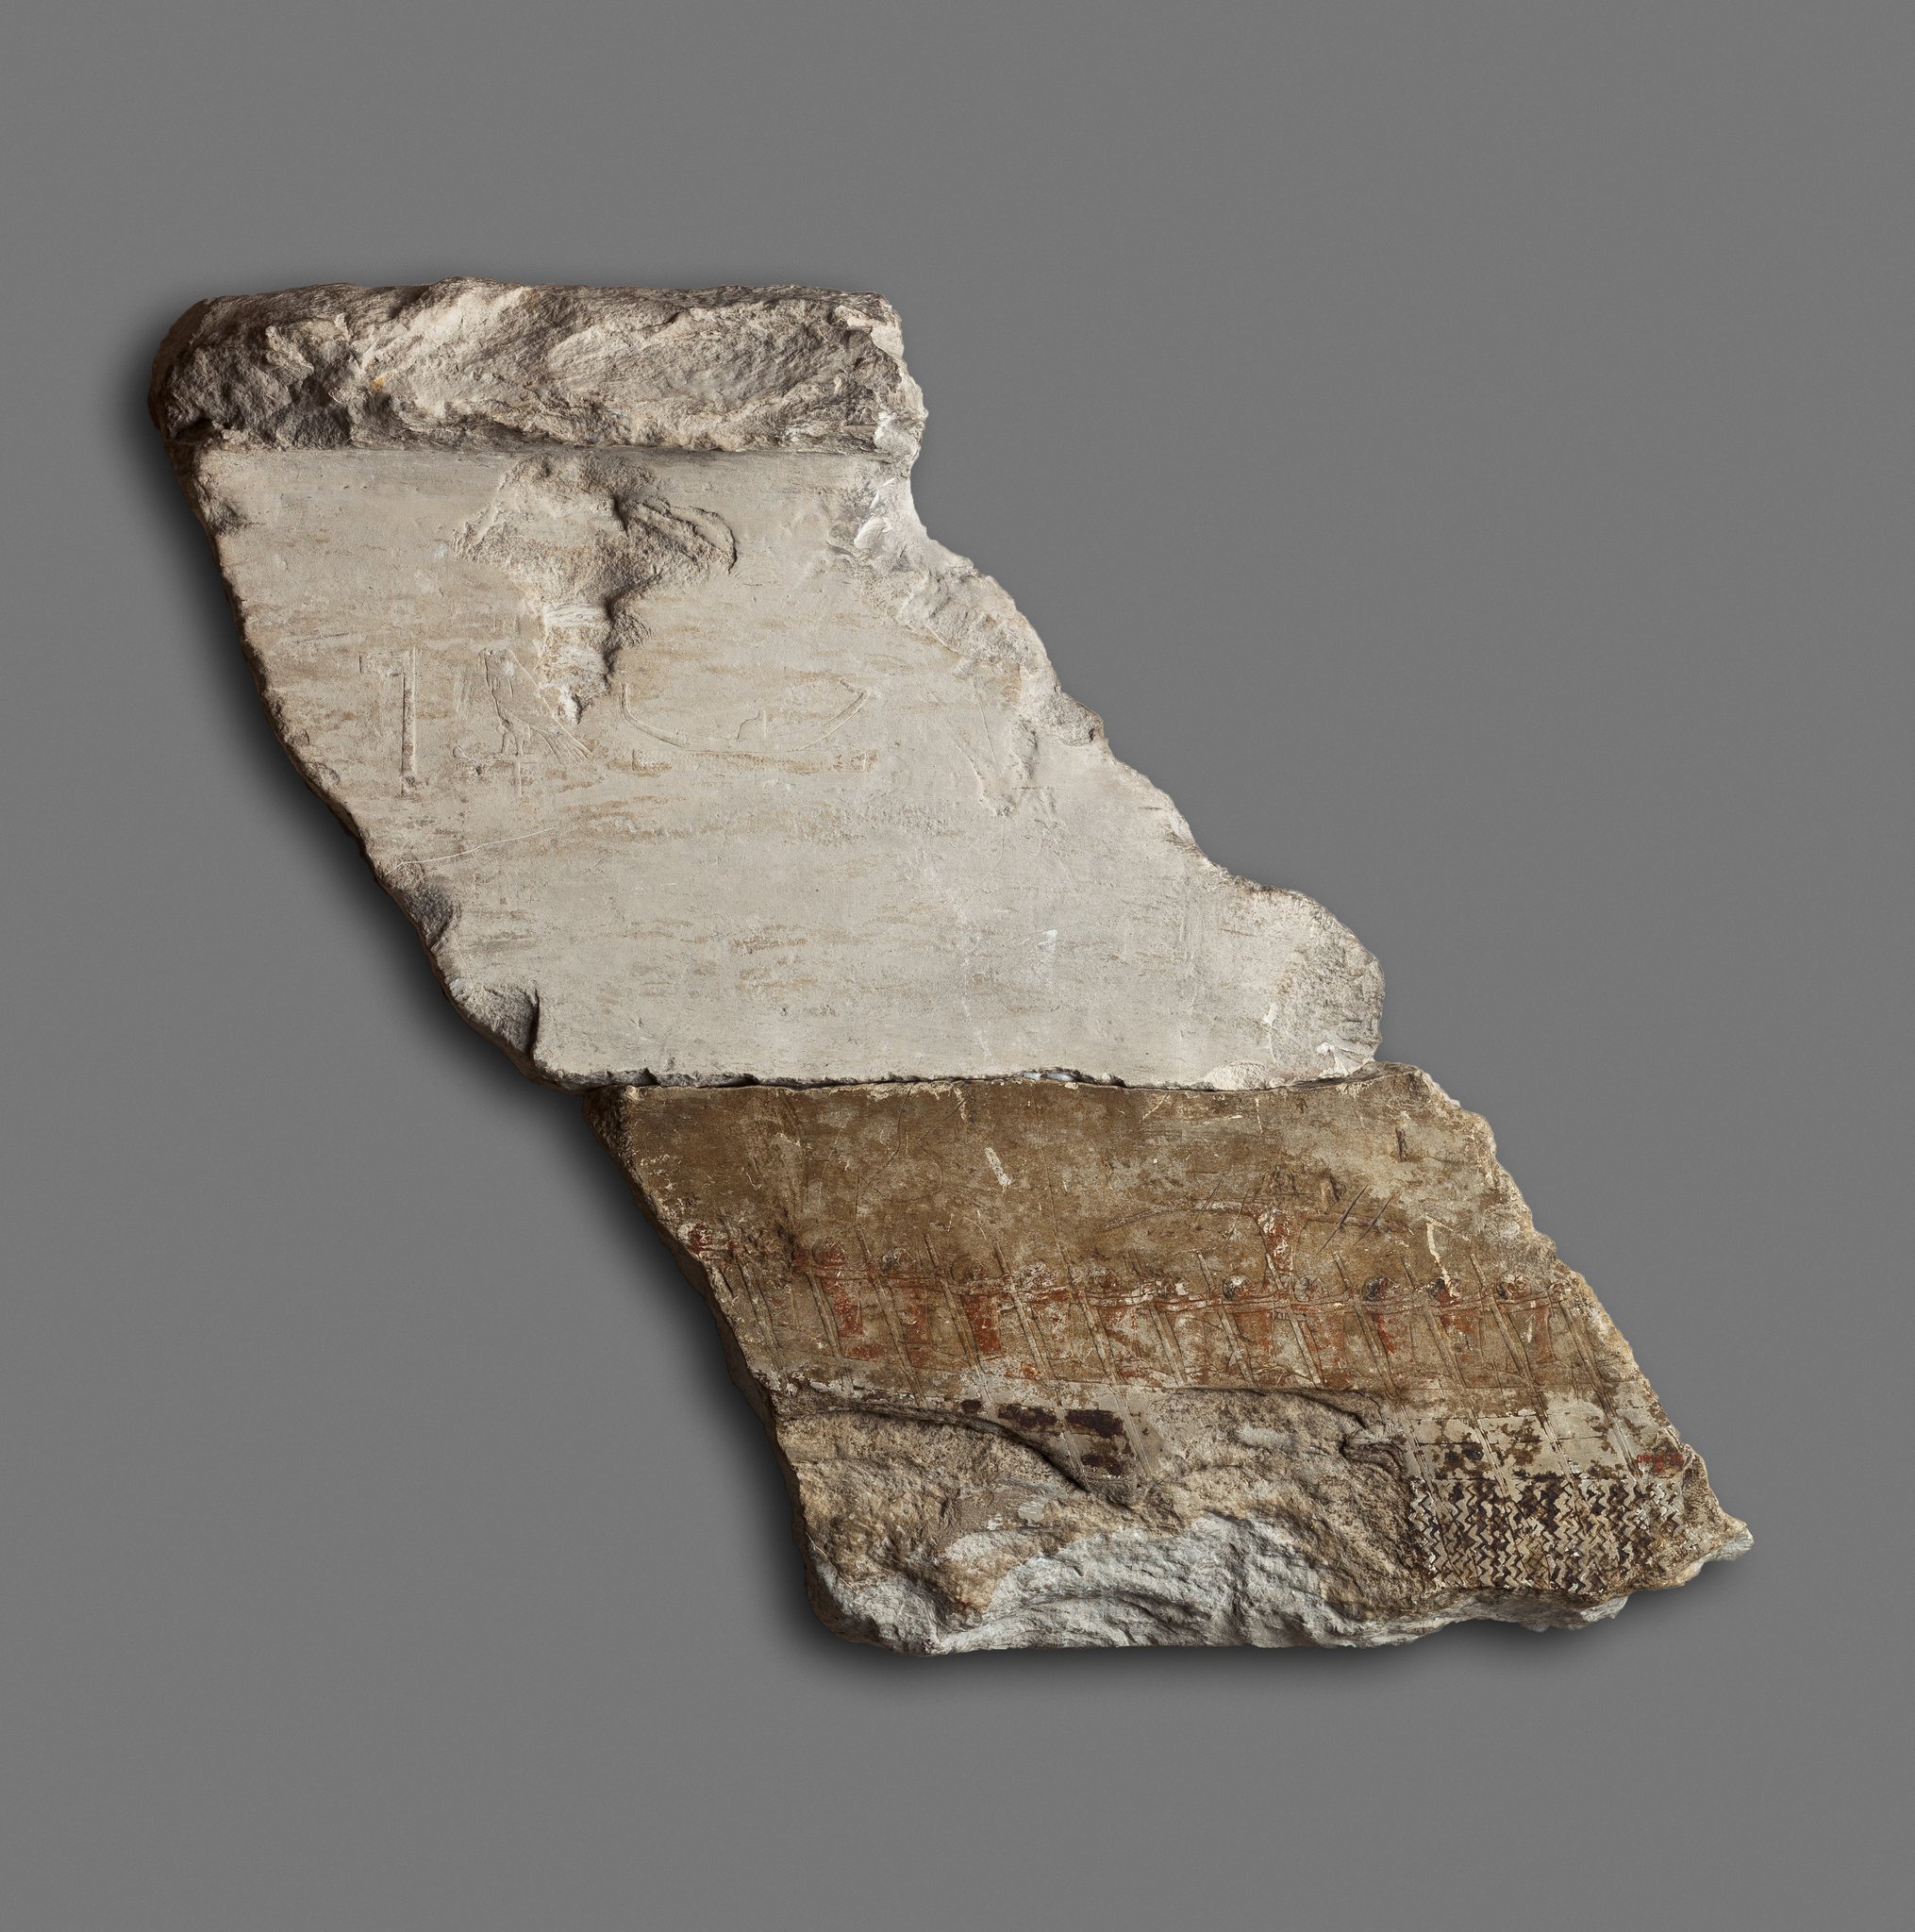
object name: relief, royal ship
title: Relief showing a royal ship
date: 2400-2323 BCE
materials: limestone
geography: egypt